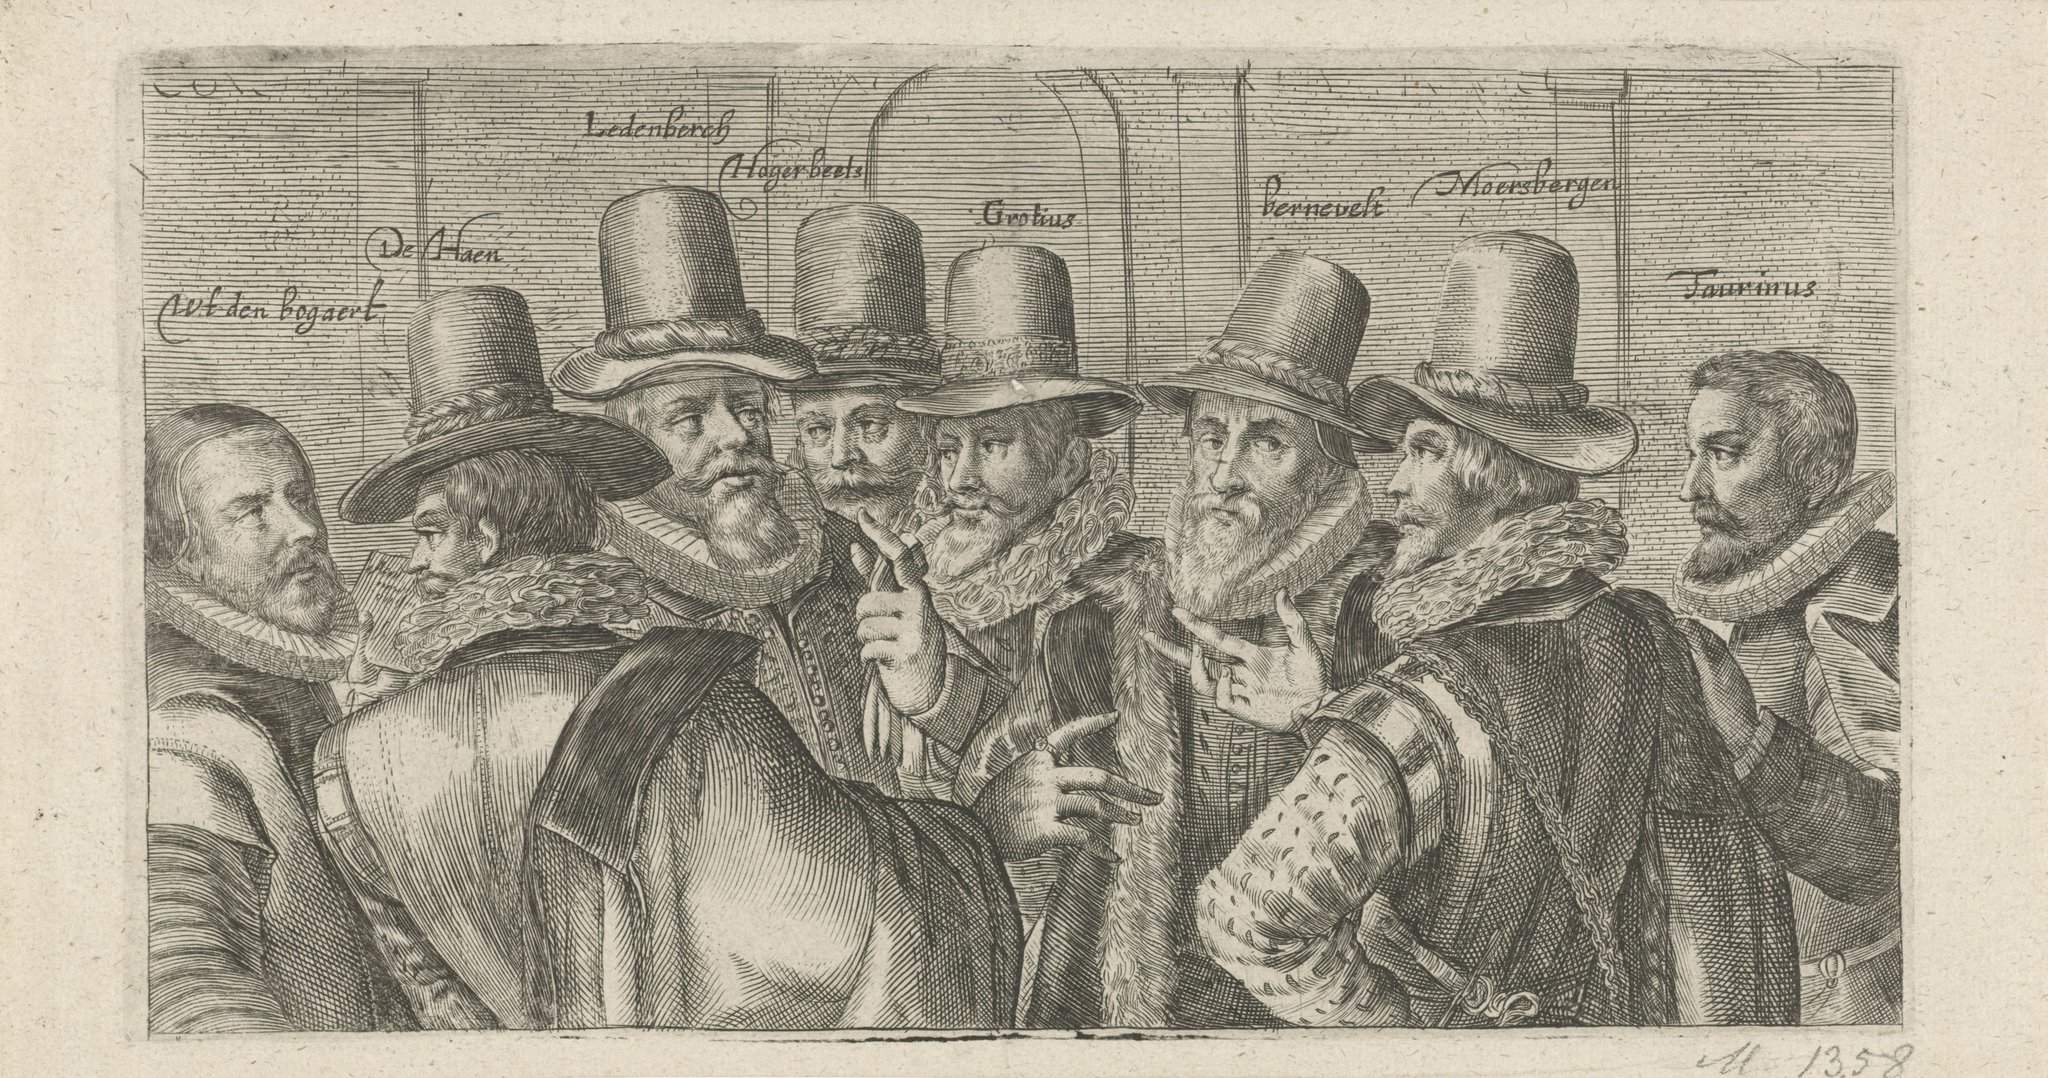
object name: cartoon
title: Spotprent op Johan van Oldenbarnevelt en zijn medestanders, 1618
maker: crispijn van de passe (i)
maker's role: draughtsman, print maker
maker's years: 1564-1637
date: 1613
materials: paper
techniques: engraving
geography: northern netherlands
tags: delft, hugo de groot, the hague, johan van oldenbarnevelt, antwerp, utrecht, hoorn (north holland), coat (+ men's clothes), historical persons, head-gear: hat (+ men's clothes), beard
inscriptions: collector's mark: Lugt 240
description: Johan van Oldenbarnevelt en zijn medestanders, met elkaar in gesprek, 1618. De geportretteerden zijn met naam aangeduid. De prent is gedrukt van een oudere plaat uit 1613 met de betrokkenen bij het buskruitverraad, waarbij de Engelse namen en de Latijnse, Franse en Duitse teksten zijn verwijderd. De gezichten zijn aangepast op de Nederlandse geportretteerden.